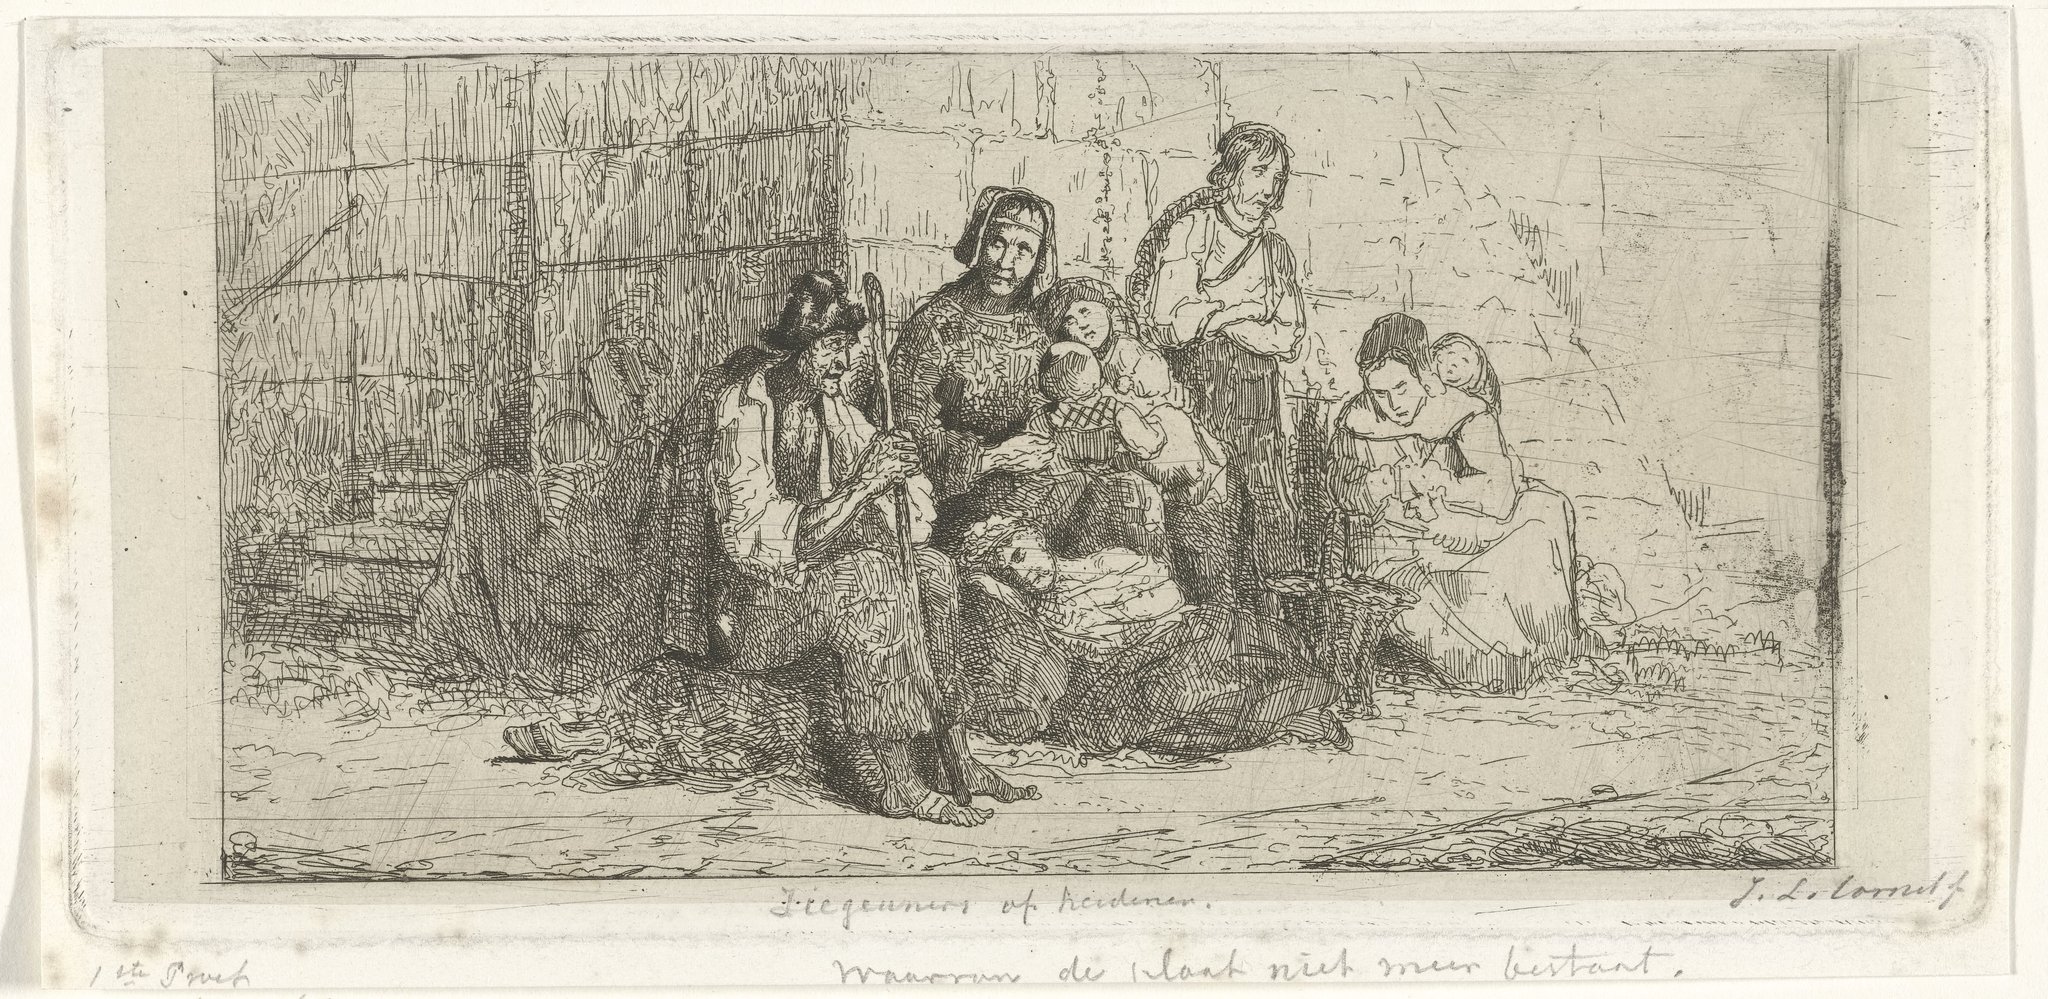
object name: print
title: Groep zigeuners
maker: jacobus ludovicus cornet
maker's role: draughtsman, print maker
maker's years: 1815-1882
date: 1825-1882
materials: paper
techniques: etching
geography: leiden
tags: wandering communities: romani or roma, outcasts, pariahs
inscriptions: collector's mark: Lugt 2228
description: Een groep zigeuners, in lompen gekleed, zitten tegen een muur aan de straatkant.